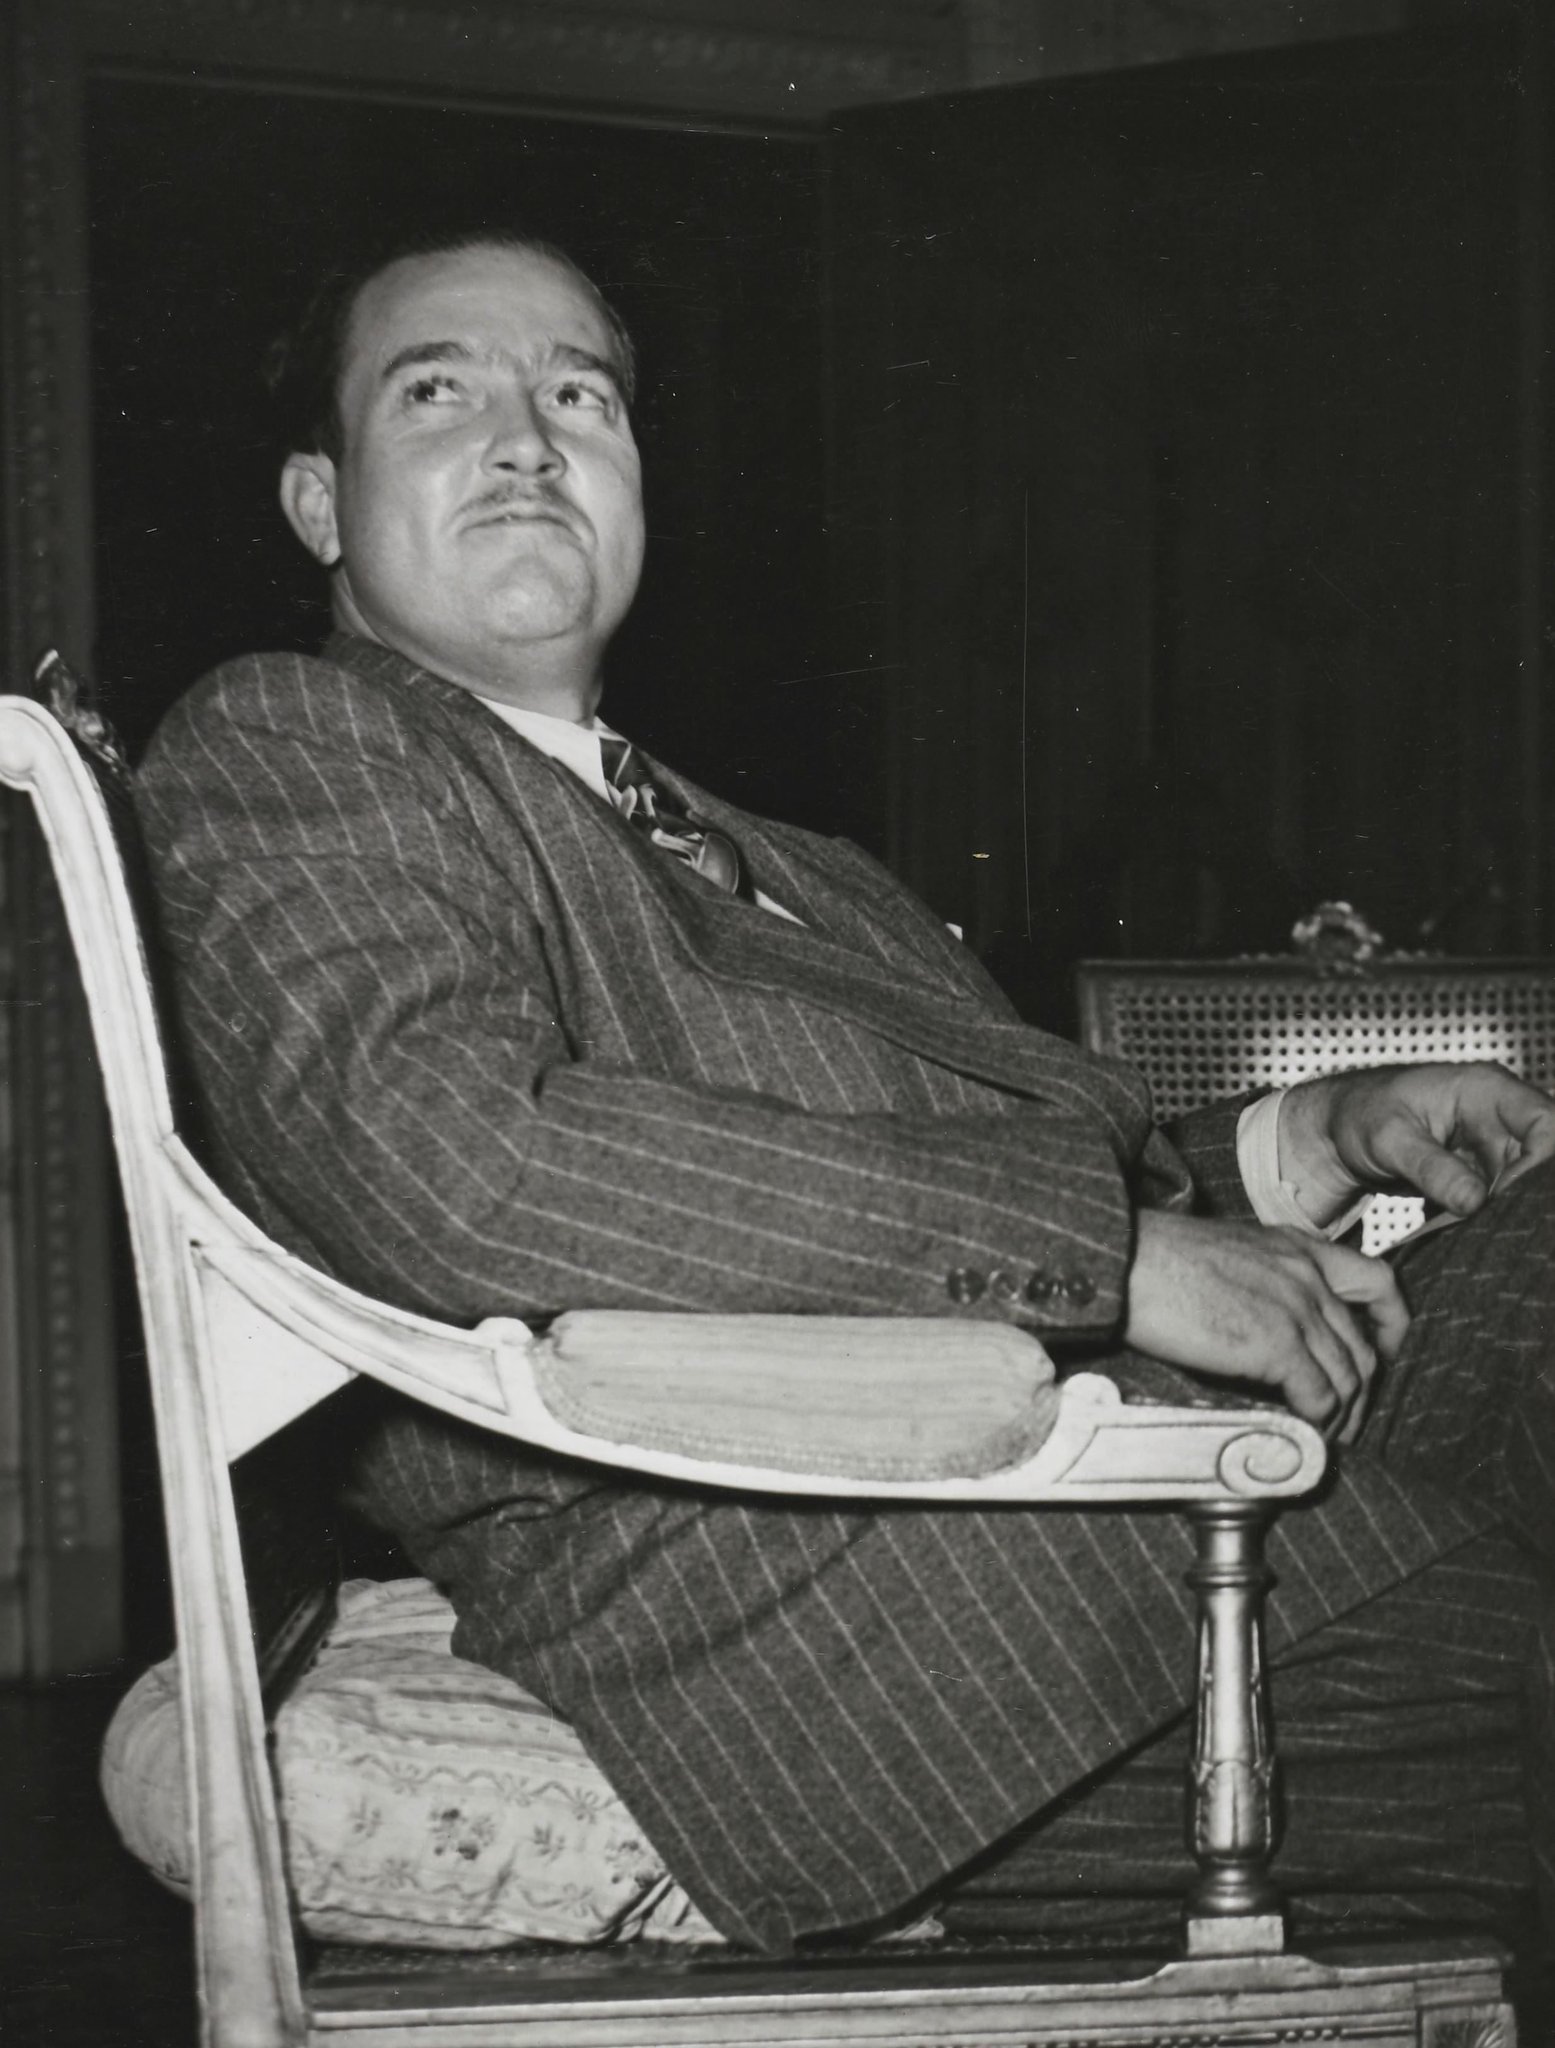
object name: documentary photograph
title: Een van de deelnemers aan de RTC: C.A. Eman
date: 1902-1948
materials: photographic support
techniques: photography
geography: the hague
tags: politician, netherlands, suriname, the hague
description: Een van de deelnemers namens Curaçao aan de Ronde Tafel Conferentie tussen Nederland en de West: de heer C.A. Eman, advocaat en politicus. Hij is voorzitter van de Arubaanse Volkspartij, de enige partij op Aruba.